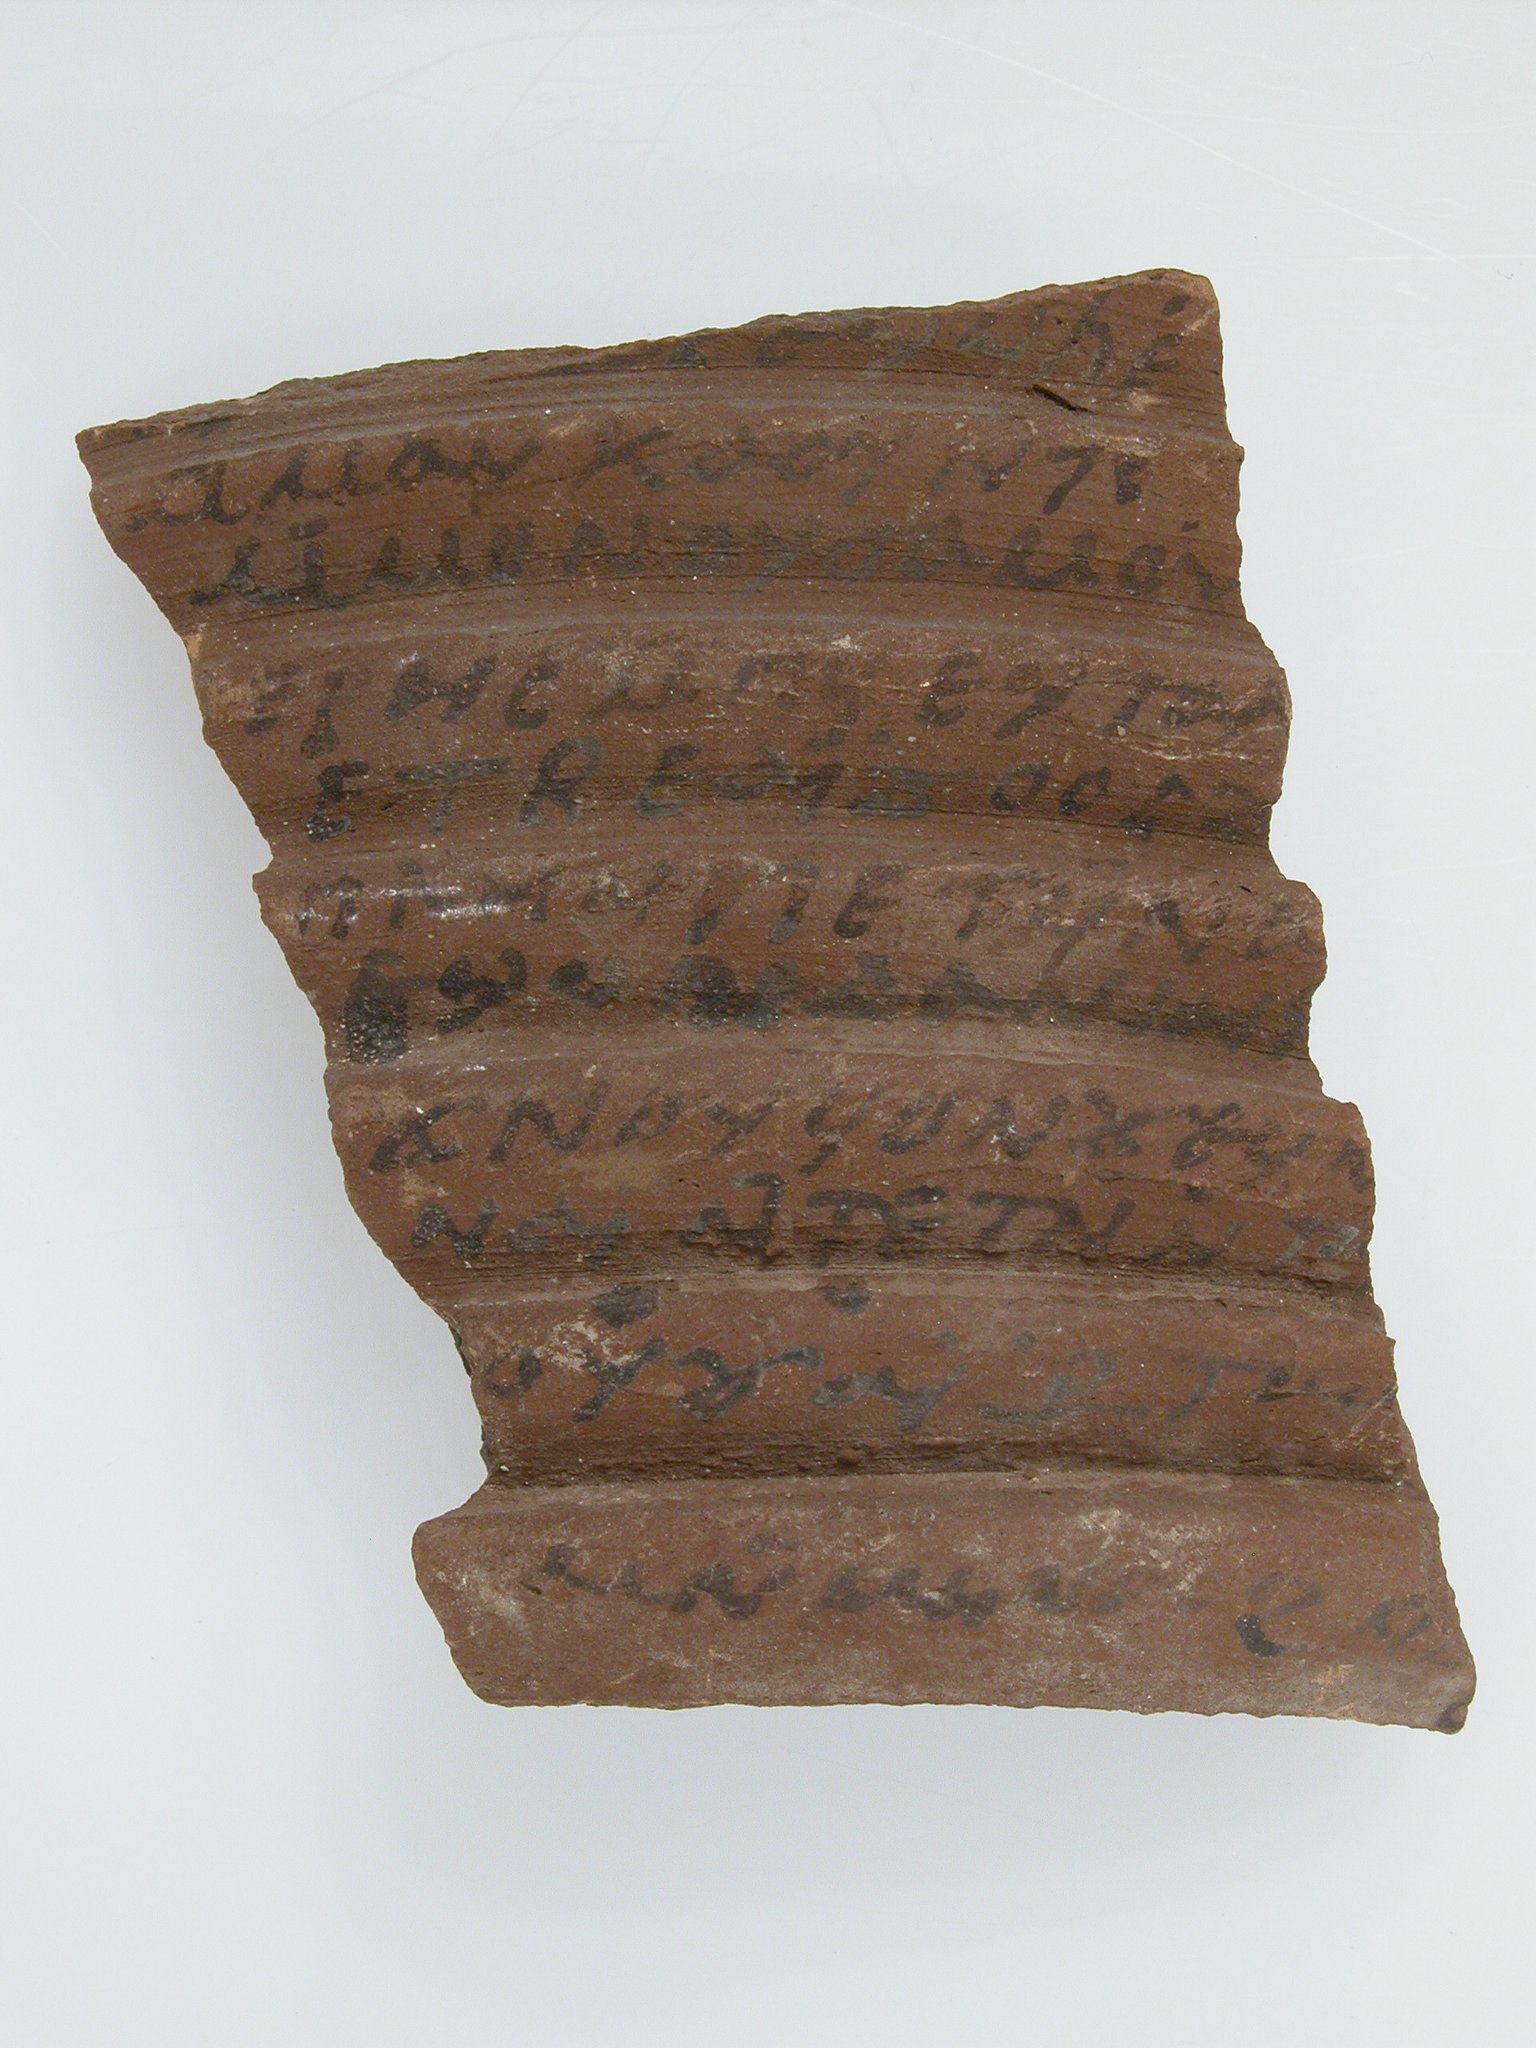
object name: ostrakon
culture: coptic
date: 600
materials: ink, pottery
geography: egypt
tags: coptic,documents